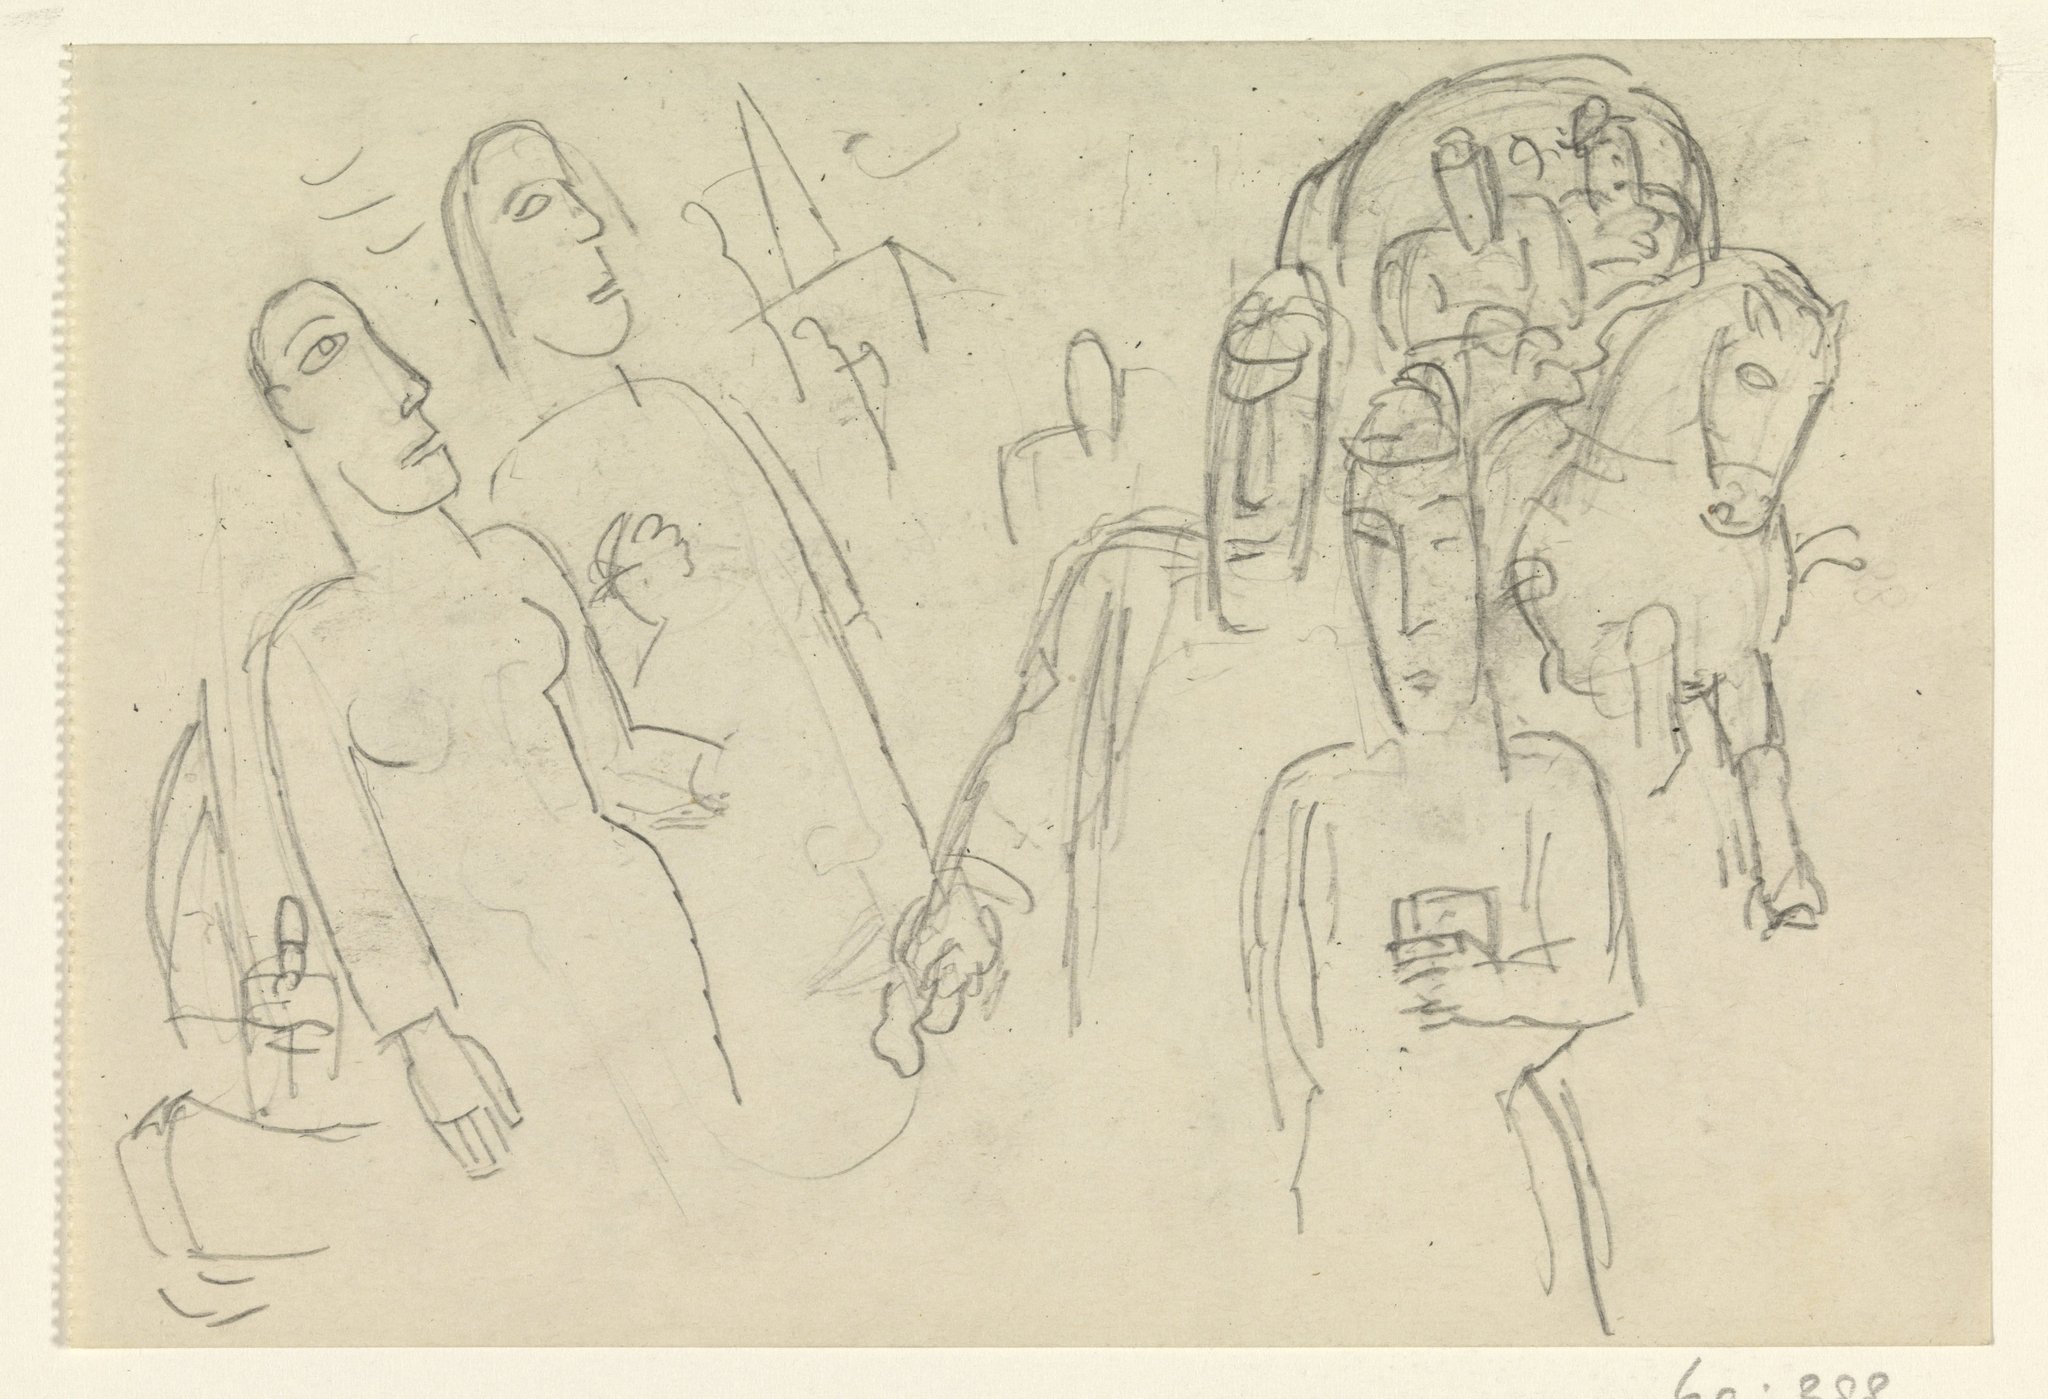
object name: drawing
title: Mensen op straat en een paard met wagen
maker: leo gestel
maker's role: draughtsman, print maker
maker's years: 1881-1941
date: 1891-1941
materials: paper, pencil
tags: horse, street, (farm) wagon, freight wagon, cart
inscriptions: collector's mark: Lugt 2228